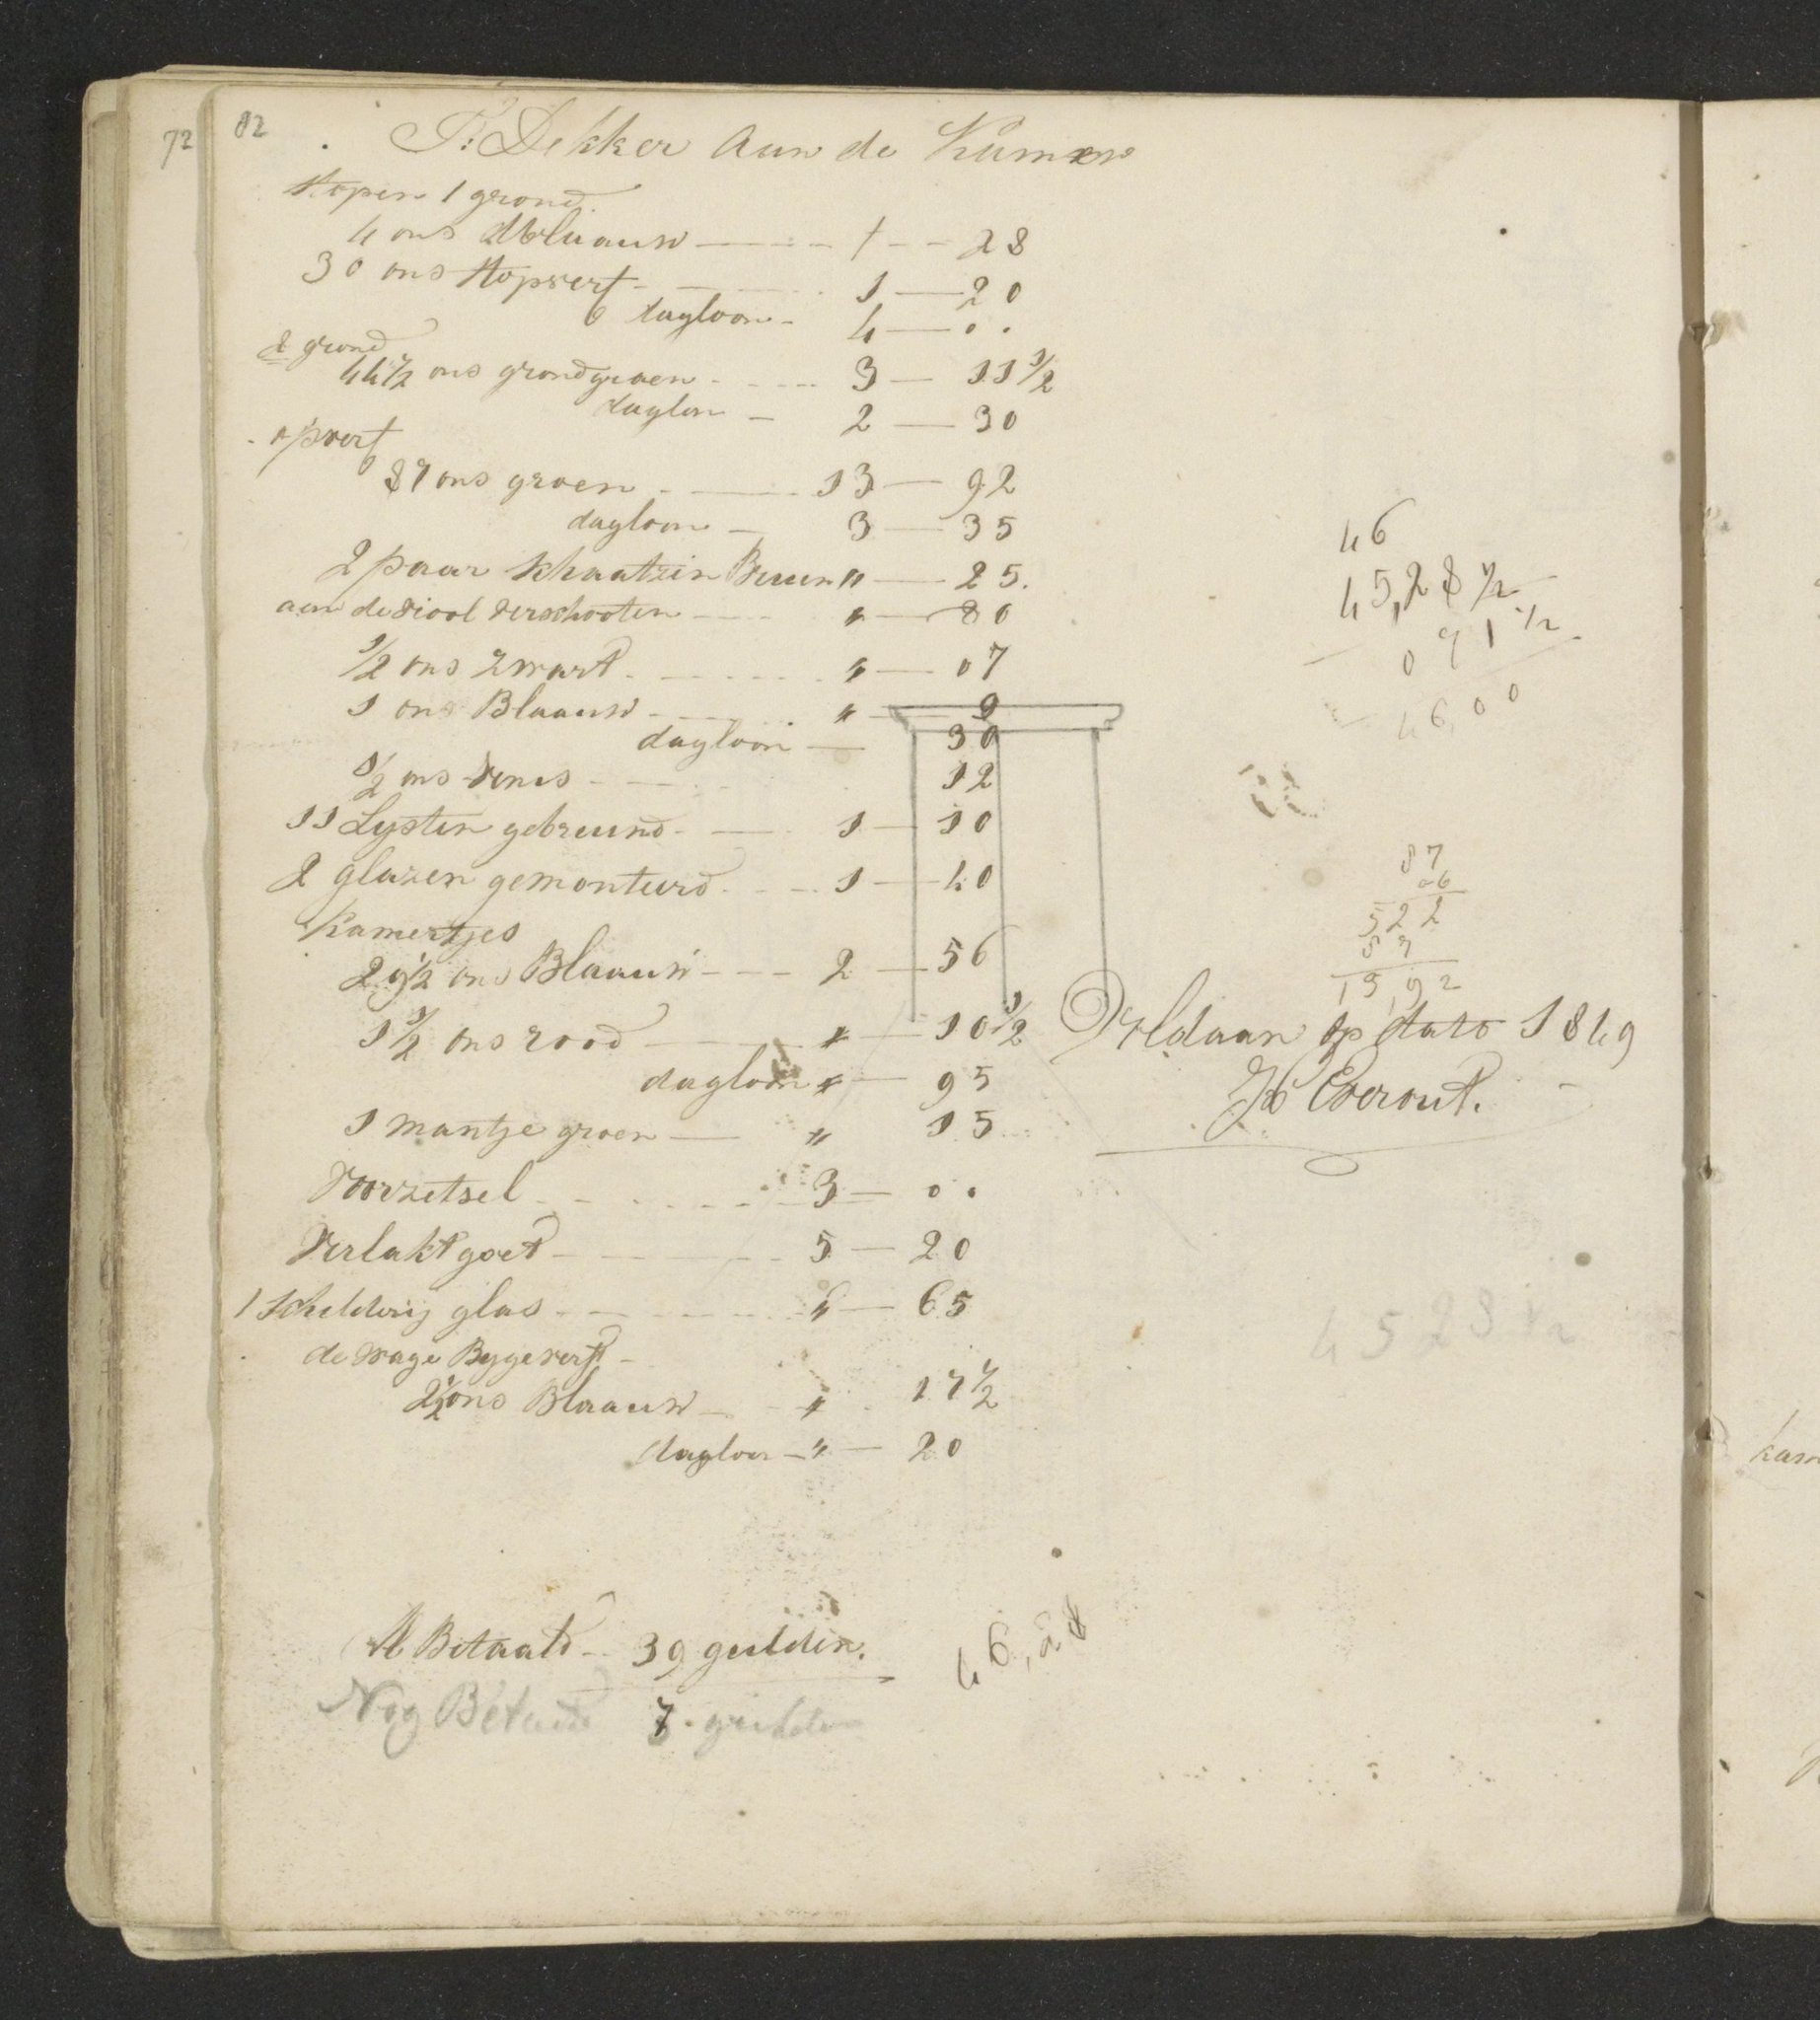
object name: sketchbook leaf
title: Zuil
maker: Anonymous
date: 1728-1732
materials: paper, pencil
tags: column, pillar ~ architecture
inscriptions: annotation: ‘T: Dekker aan de Kamer/ kope[...] 1 grond/ ...’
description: Tevens een bladzijde gebruikt als kasboek met aantekeningen over aankopen en prijzen. Bladzijde 82 uit een schetsboek met 96 bladzijden.